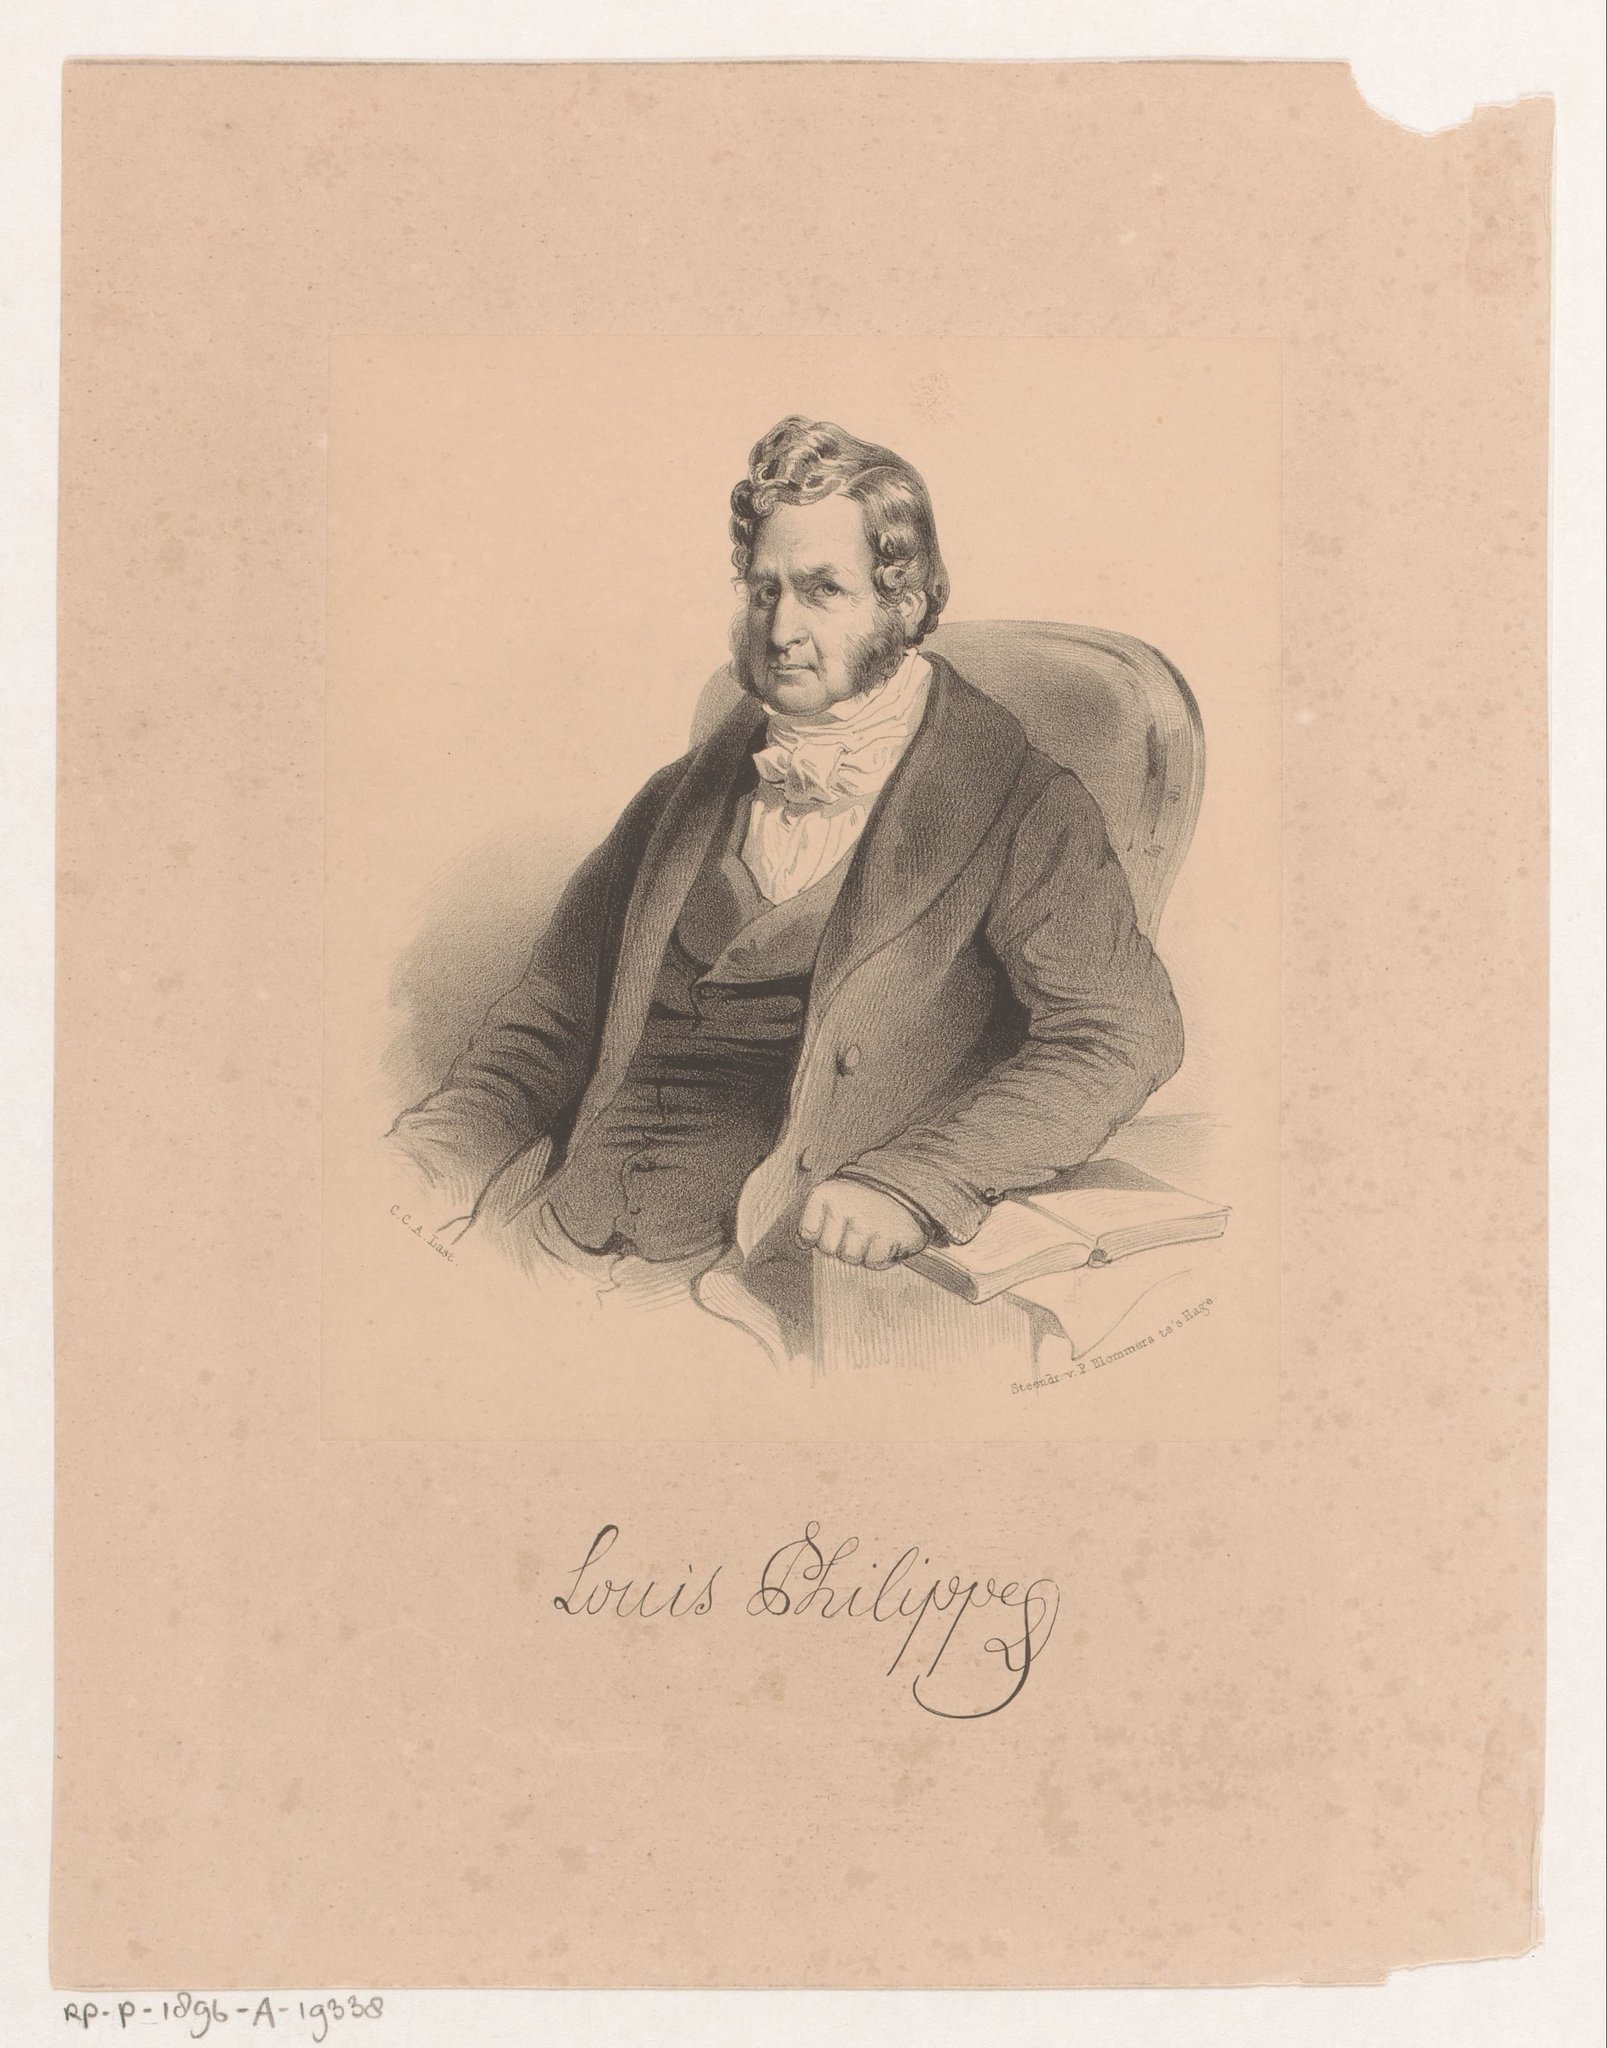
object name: print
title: Portret van Lodewijk Filips I, koning van Frankrijk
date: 1842-1887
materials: paper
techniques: lithograph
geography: netherlands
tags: paris, lodewijk filips i (koning van frankrijk), book - mm - book open, historical persons (+ half-length portrait)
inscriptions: collector's mark: Lugt 2228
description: De geportretteerde zit in een stoel en leunt met zijn linkerarm op een opengeslagen boek.